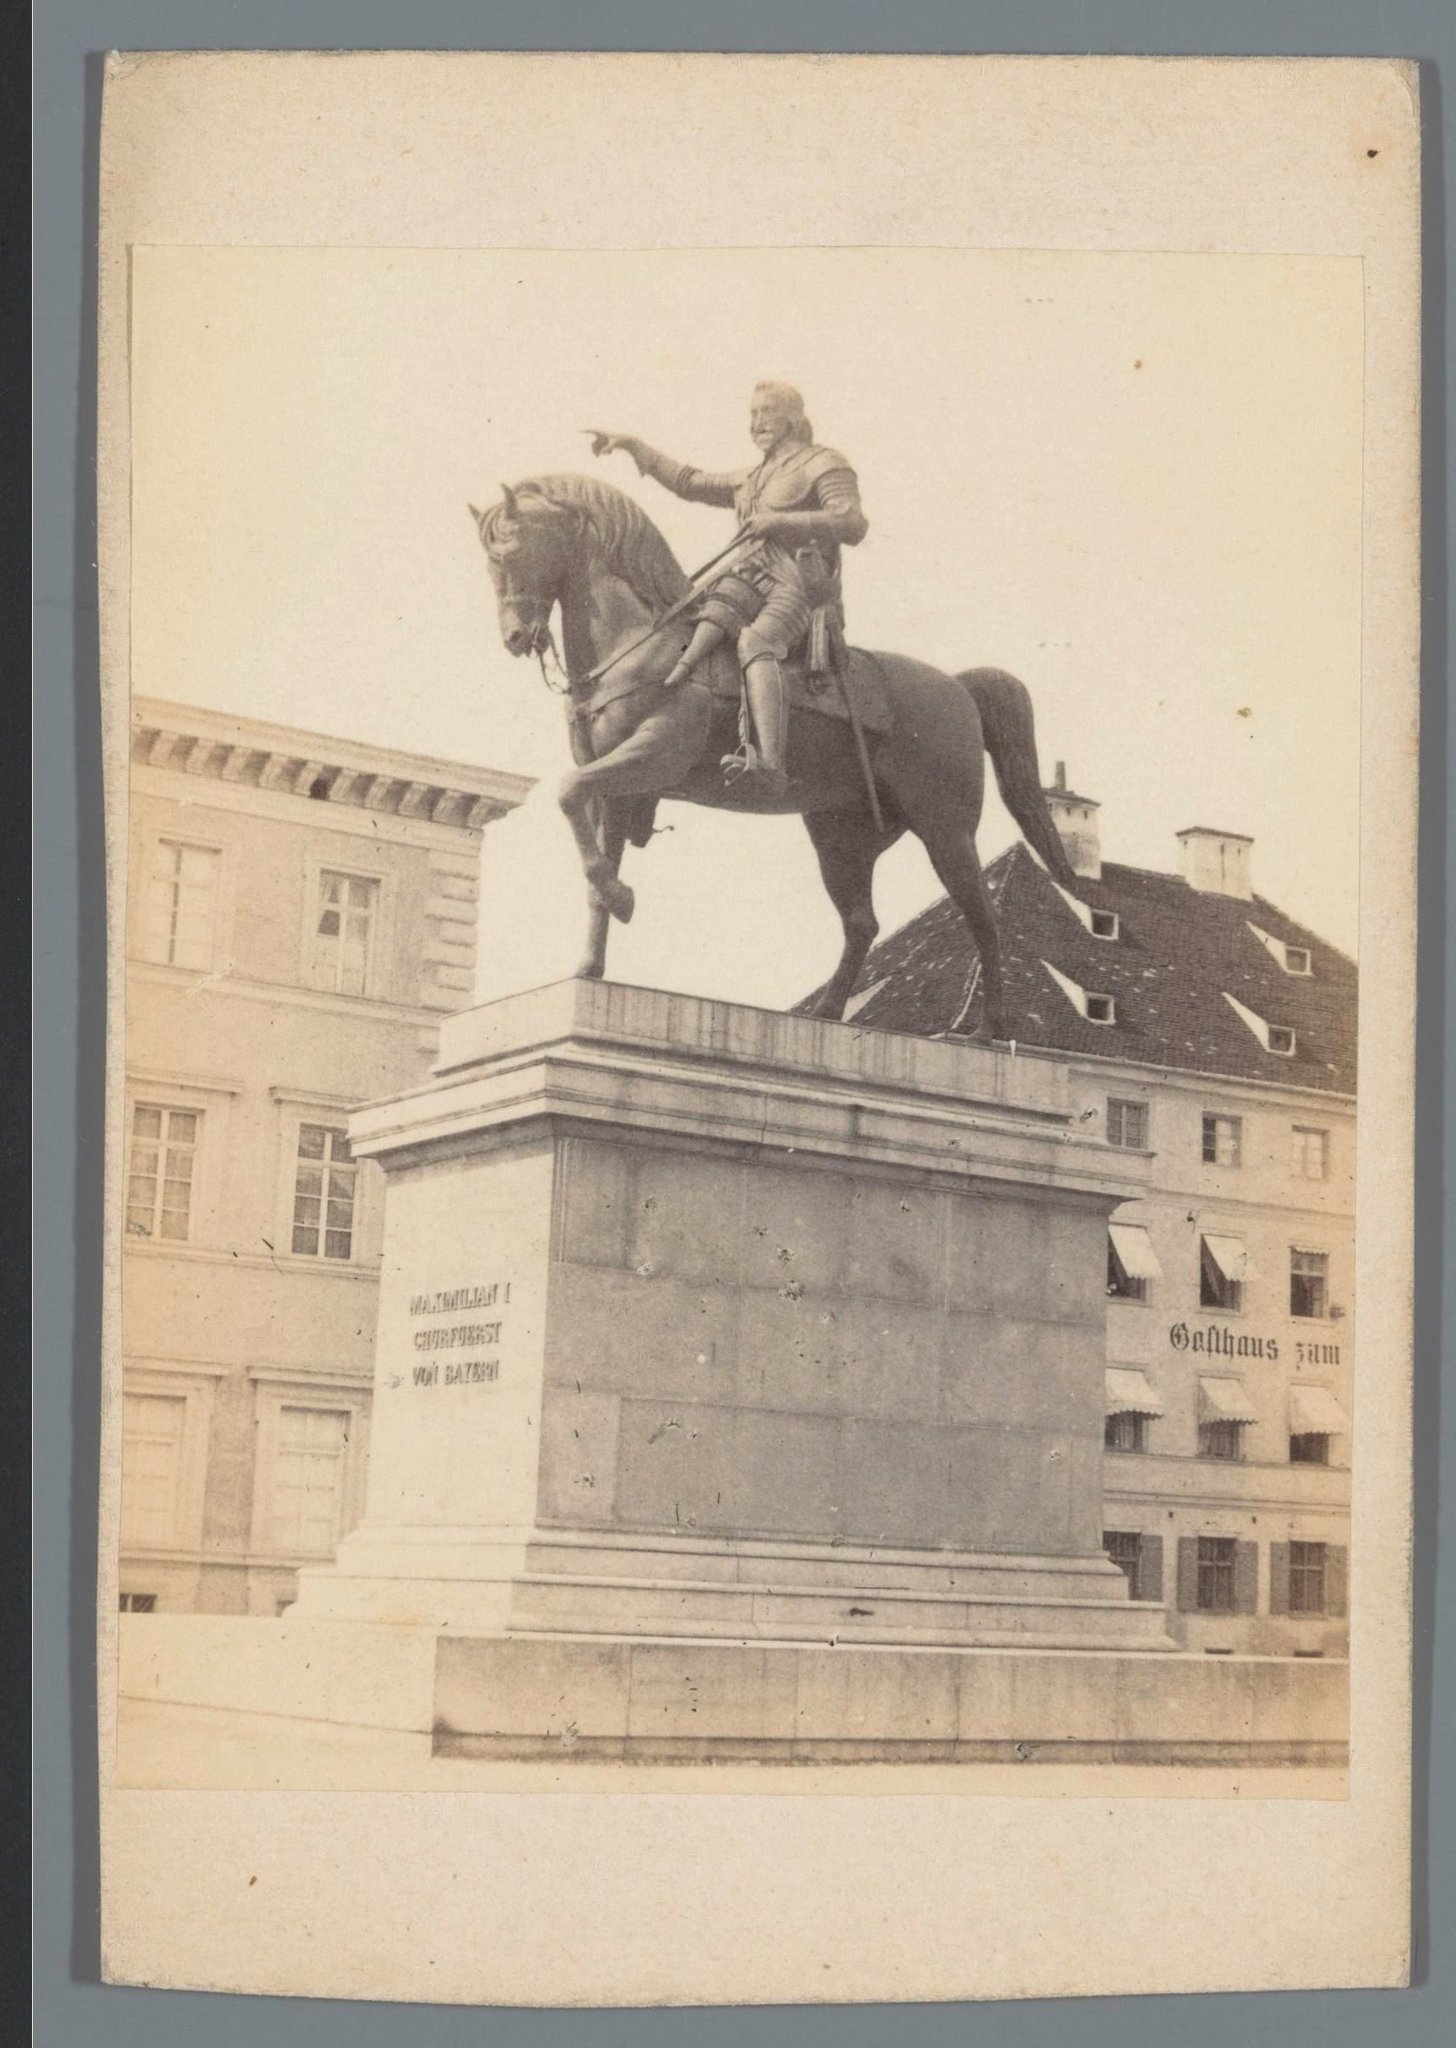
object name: photograph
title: Ruiterstandbeeld van de keurvorst Maximiliaan I in München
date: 1855-1885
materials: cardboard, paper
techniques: albumen print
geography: munich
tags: maximiliaan i (keurvorst van beieren), equestrian statue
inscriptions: stamp: ‘G. Böttger/ photograph. Kunstverlag & Atelier/ MÜNCHEN/ Kaufingerstrasse Nr. 9.’